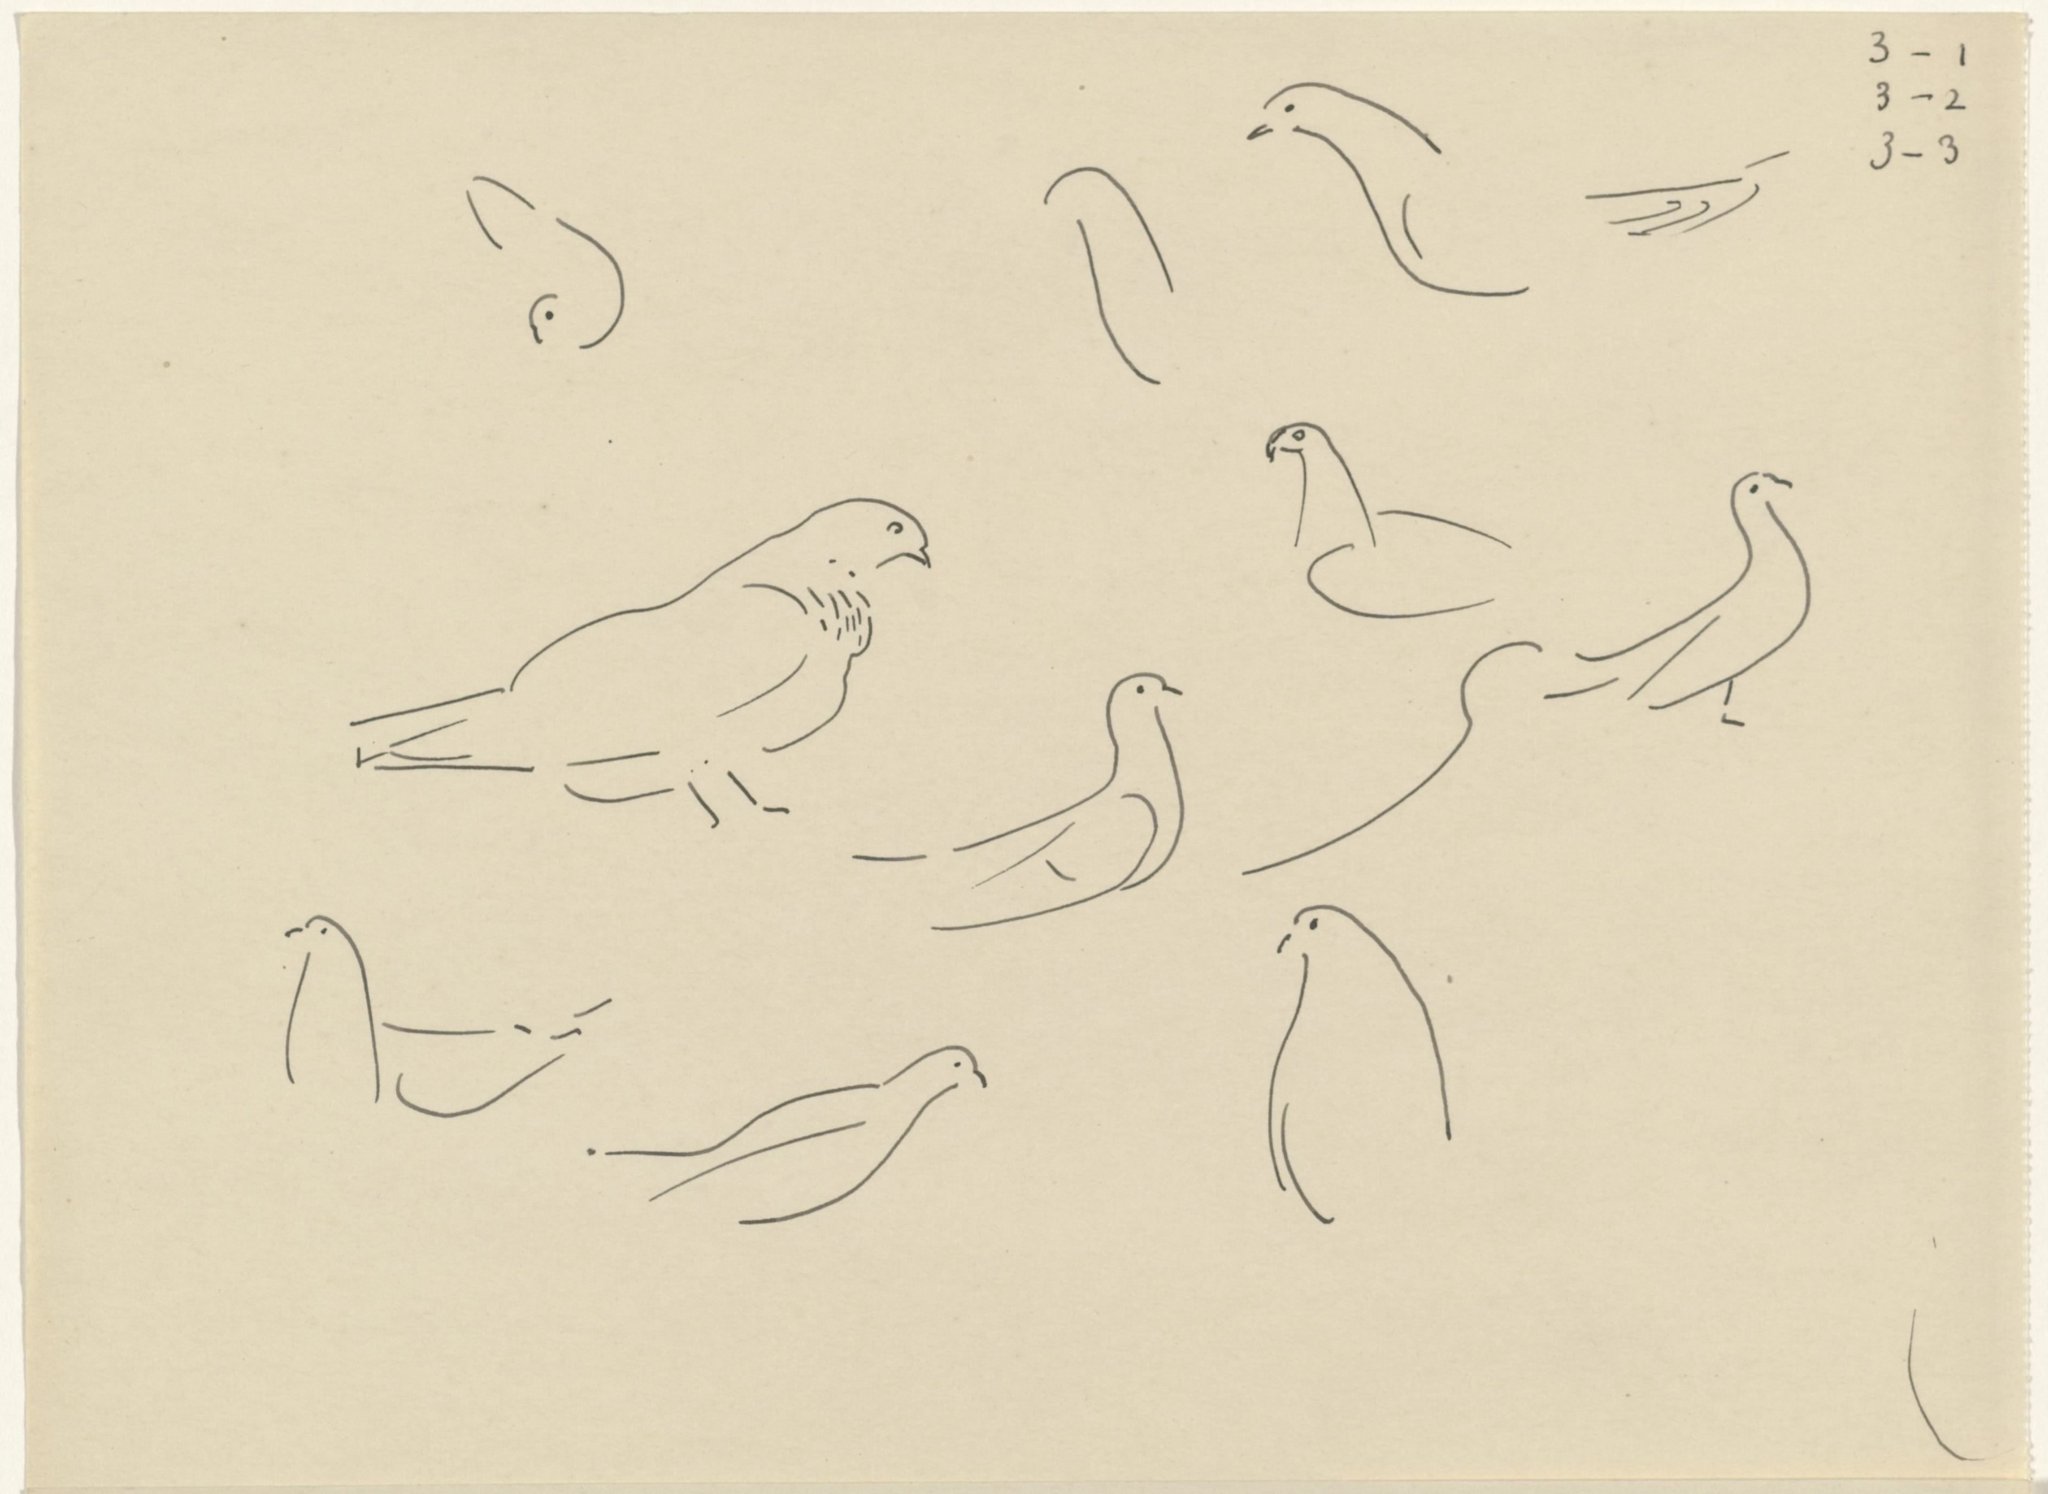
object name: drawing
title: Studies van duiven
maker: carel adolph lion cachet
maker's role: draughtsman, print maker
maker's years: 1864-1945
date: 1874-1945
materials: ink, paper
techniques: pen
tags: other birds: dove